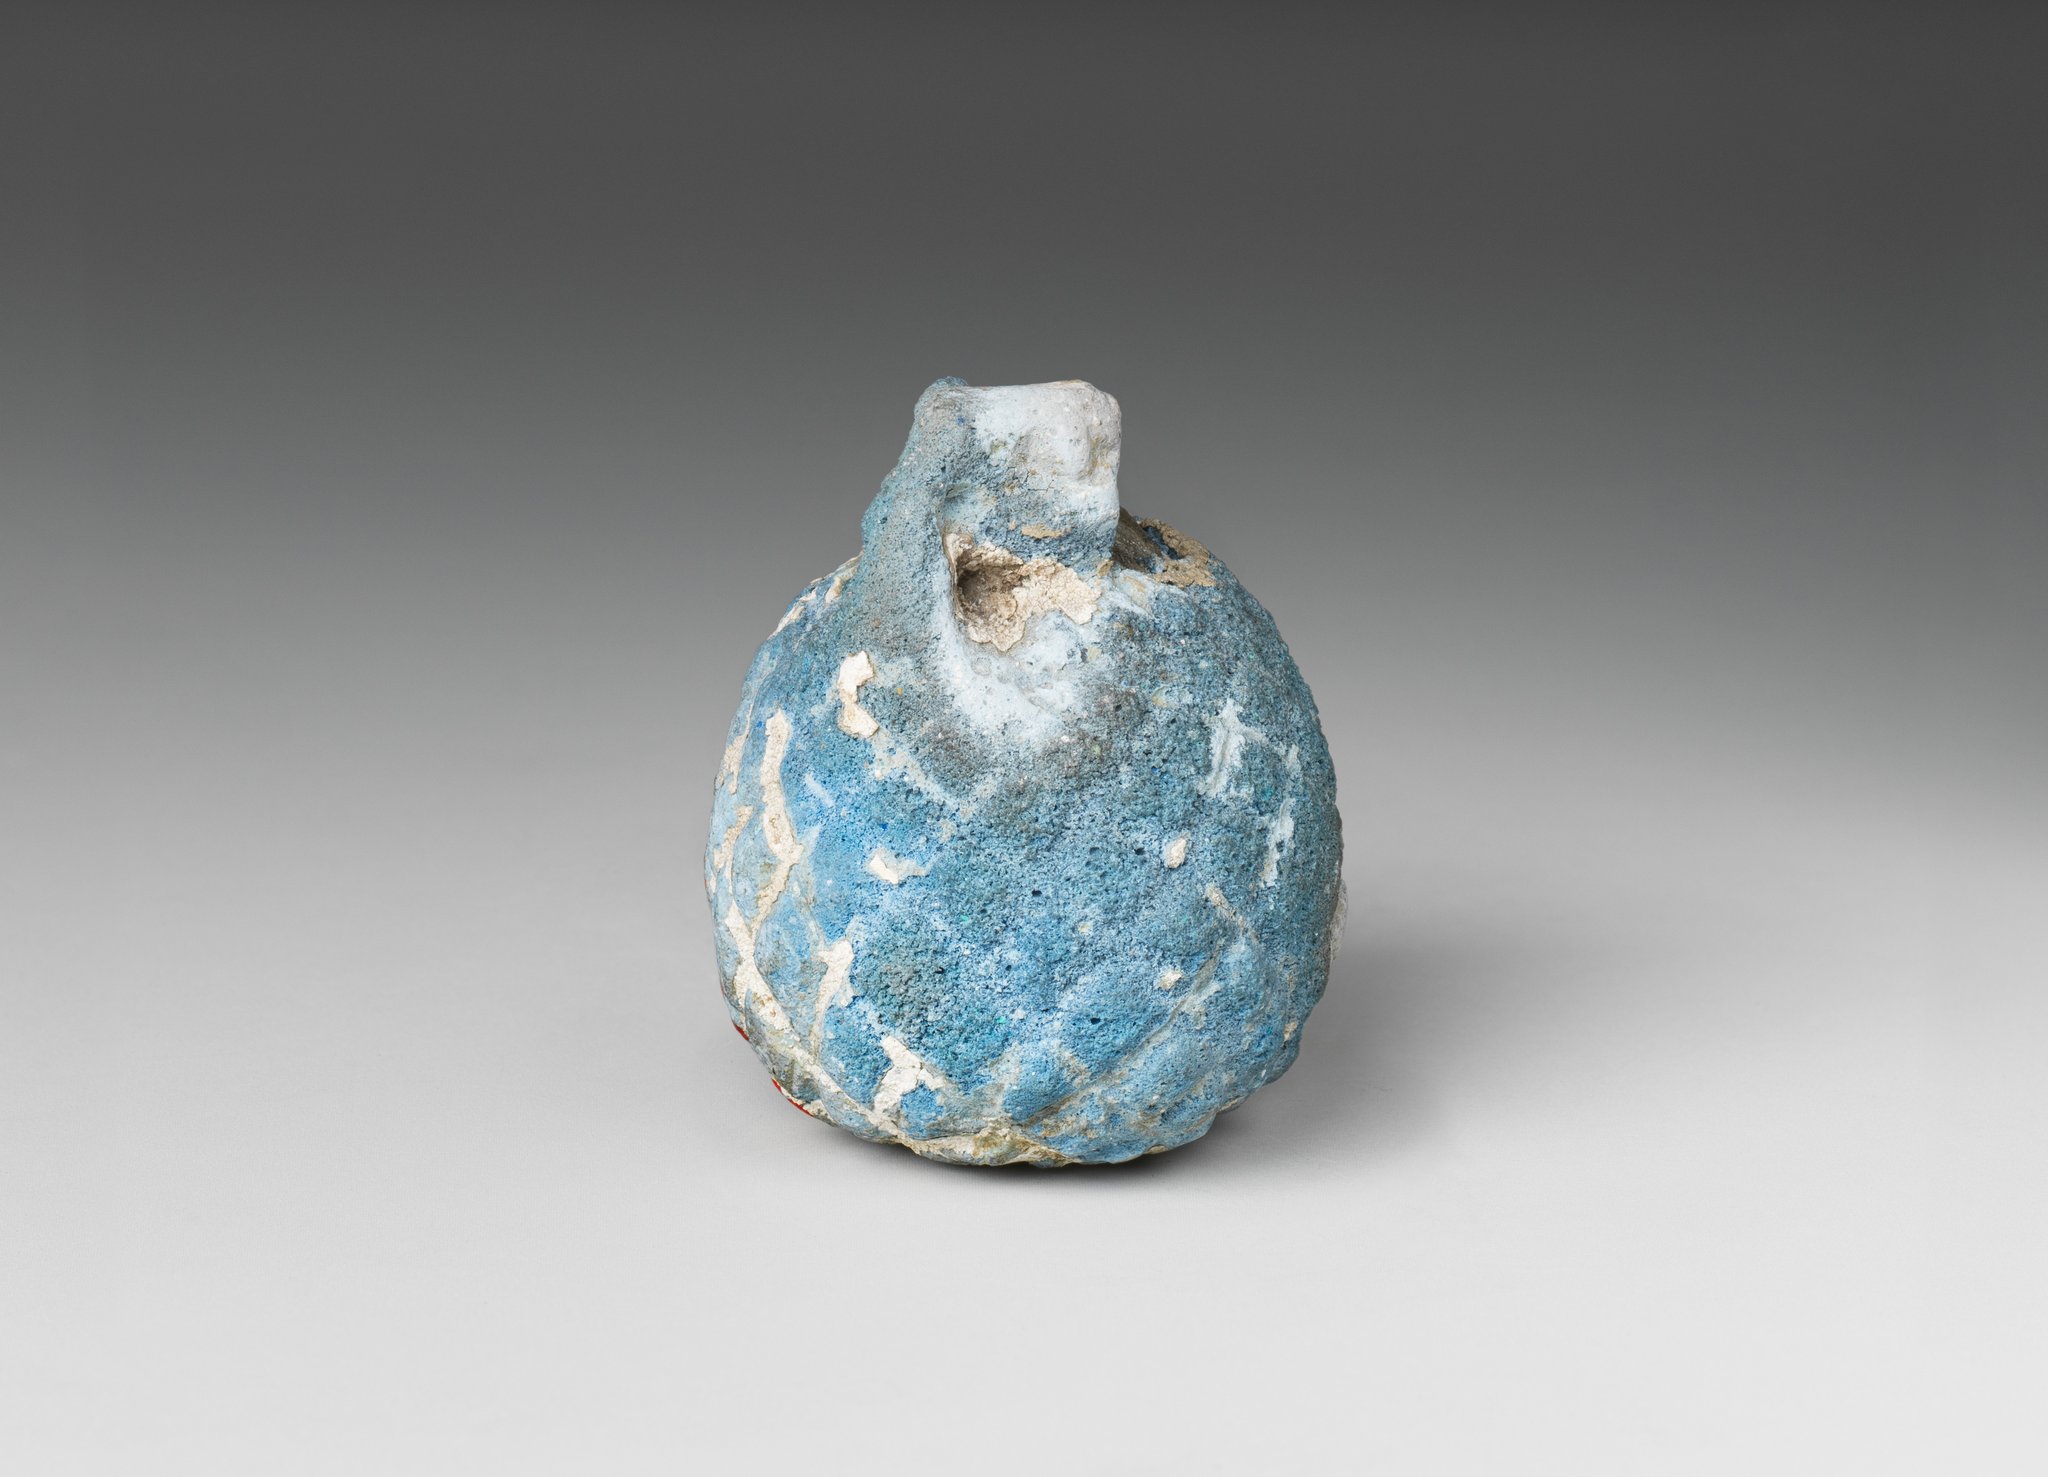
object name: miniature vessel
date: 664-332 BCE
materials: faience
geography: egypt